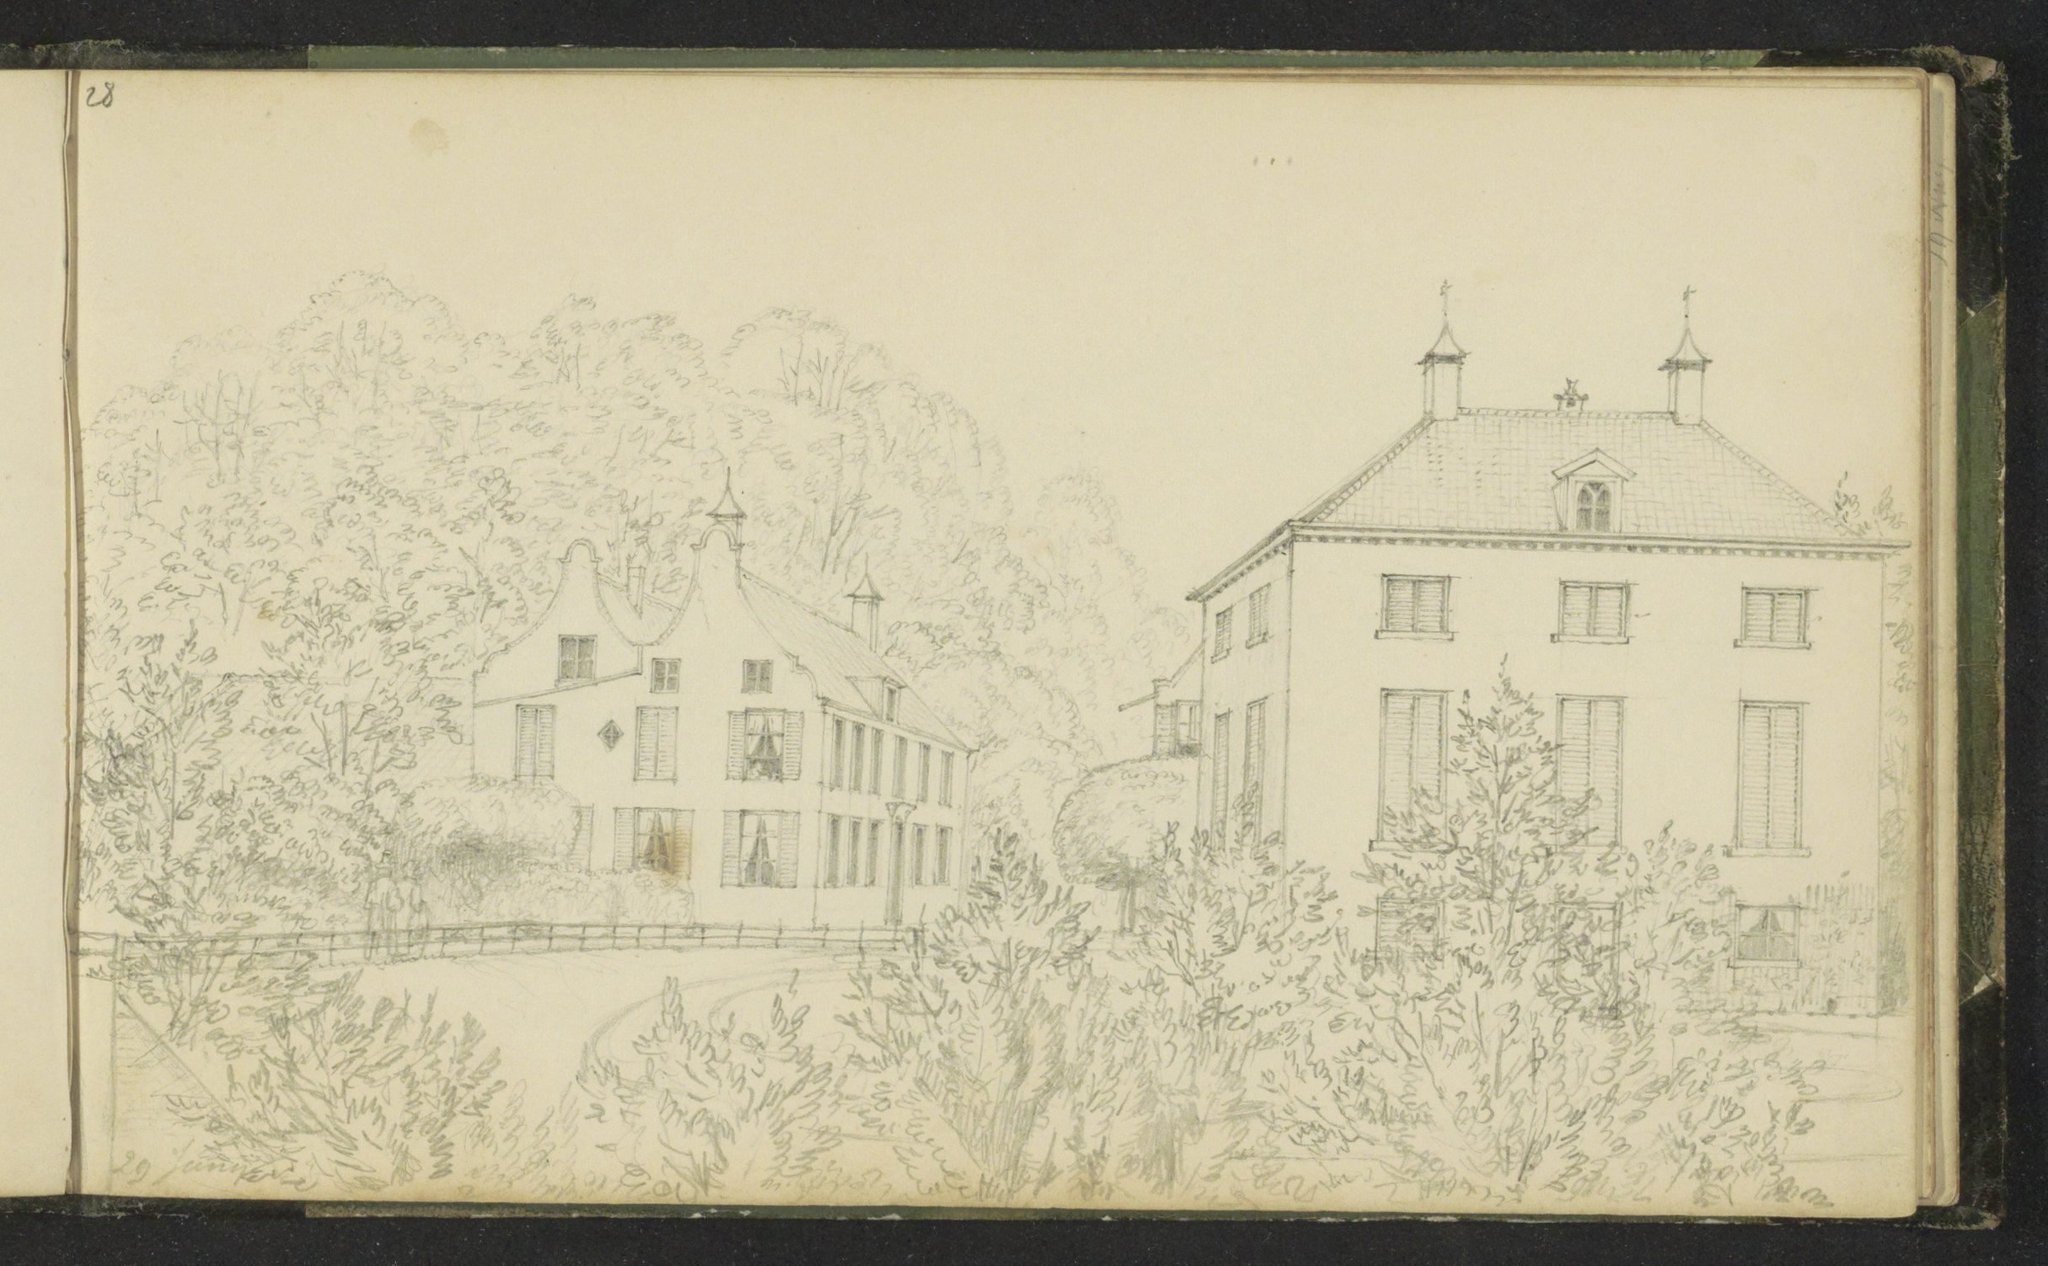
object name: sketchbook leaf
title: Twee huizen in een boomrijke omgeving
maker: hendrik abraham klinkhamer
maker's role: draughtsman, painter, print maker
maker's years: 1810-1872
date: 1806-1843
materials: paper, pencil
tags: rural housing, e.g. country-house, villa, cottage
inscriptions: date: ‘29 Junij 1843’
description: Blad 28 recto uit een schetsboek met 40 bladen.